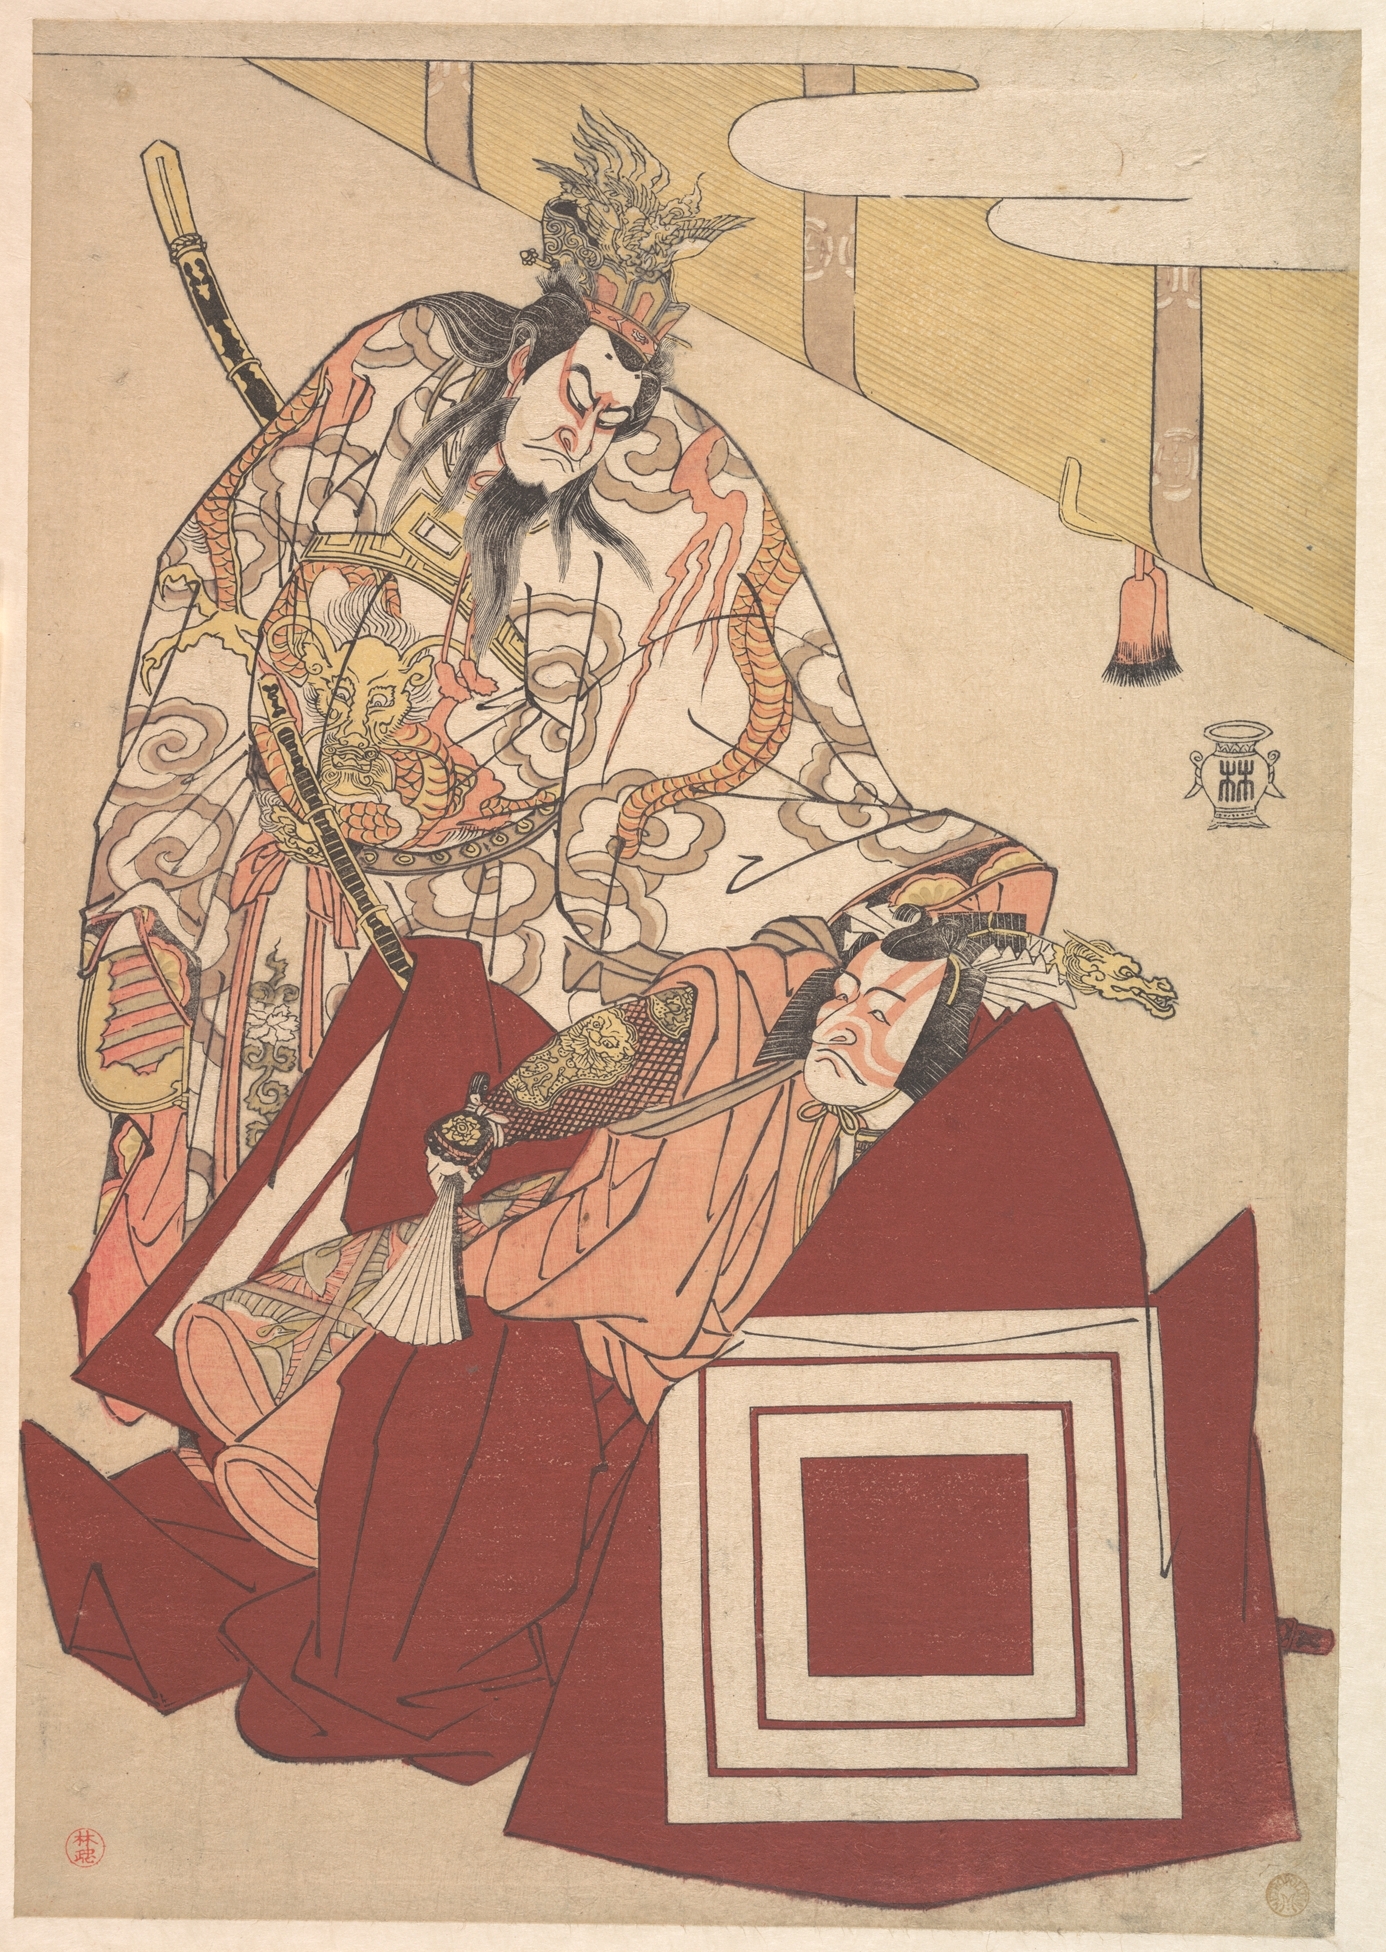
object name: woodblock print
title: Ichikawa Danjuro V in a Shibaraku Performance from the Play Mutsu no Hana no kata age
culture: japanese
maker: katsukawa shunkō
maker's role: artist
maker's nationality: japanese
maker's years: 1743-1812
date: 1786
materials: ink, paper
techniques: woodblock print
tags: performance,theatre,men,actors